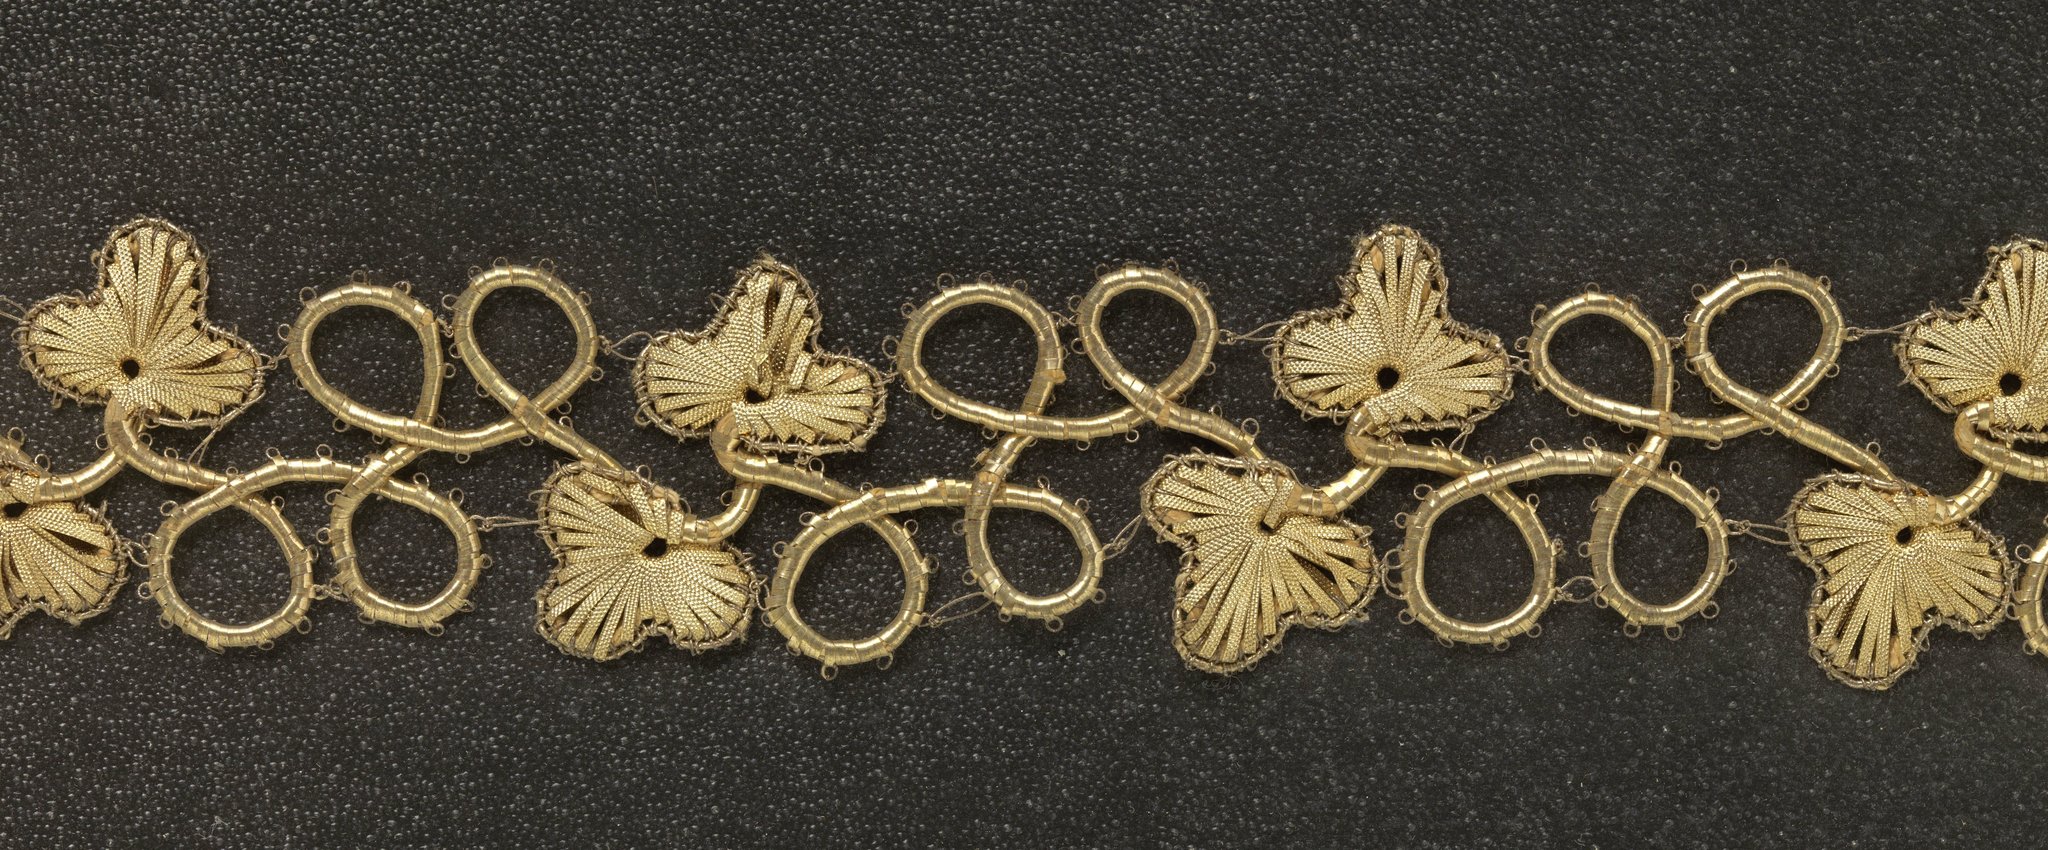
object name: fragment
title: Fragment goudgalon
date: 1800-1900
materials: gold galloon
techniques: goudgalon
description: Fragment goudgalon, versierd met slingers met bloemen en een tak met bladeren en bloemen.